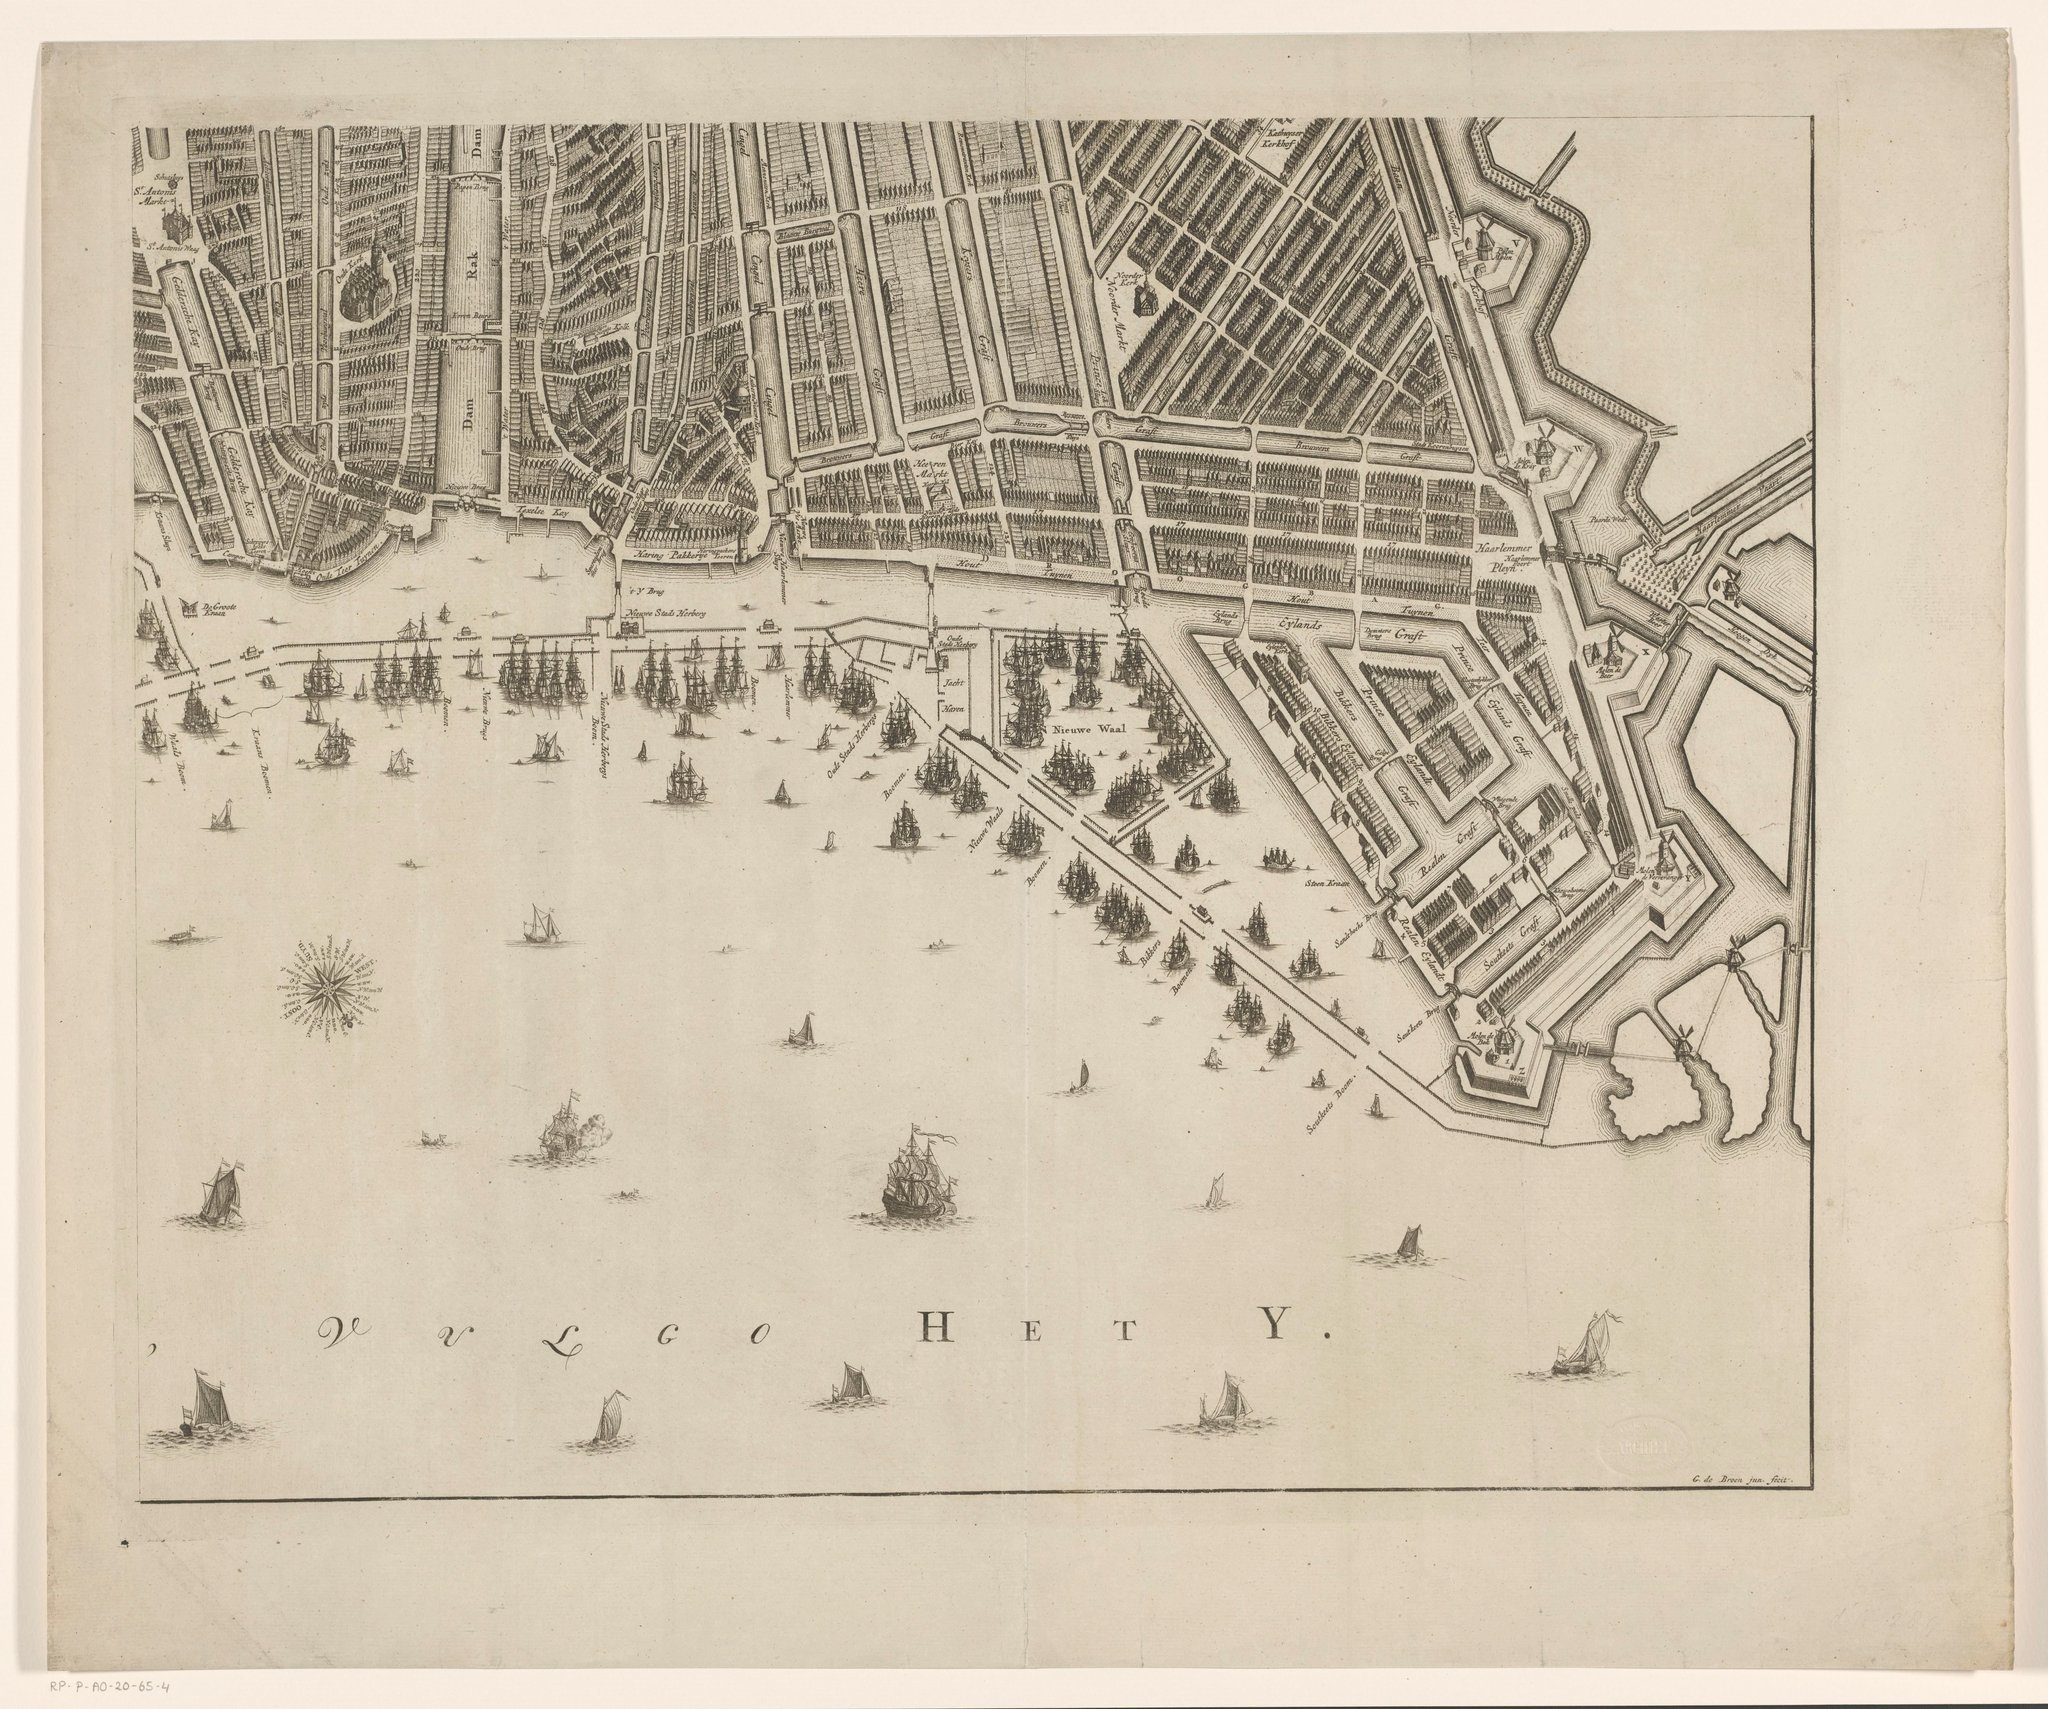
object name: print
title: Plattegrond van Amsterdam (deel rechtsonder)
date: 1724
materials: paper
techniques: engraving, etching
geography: amsterdam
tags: maps of cities, amsterdam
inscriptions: check stamp: ‘Archief Ministerie van Oorlog Afdeeling Genie’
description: Deel (rechtsonder) van een plattegrond van Amsterdam, bestaande uit vier delen.